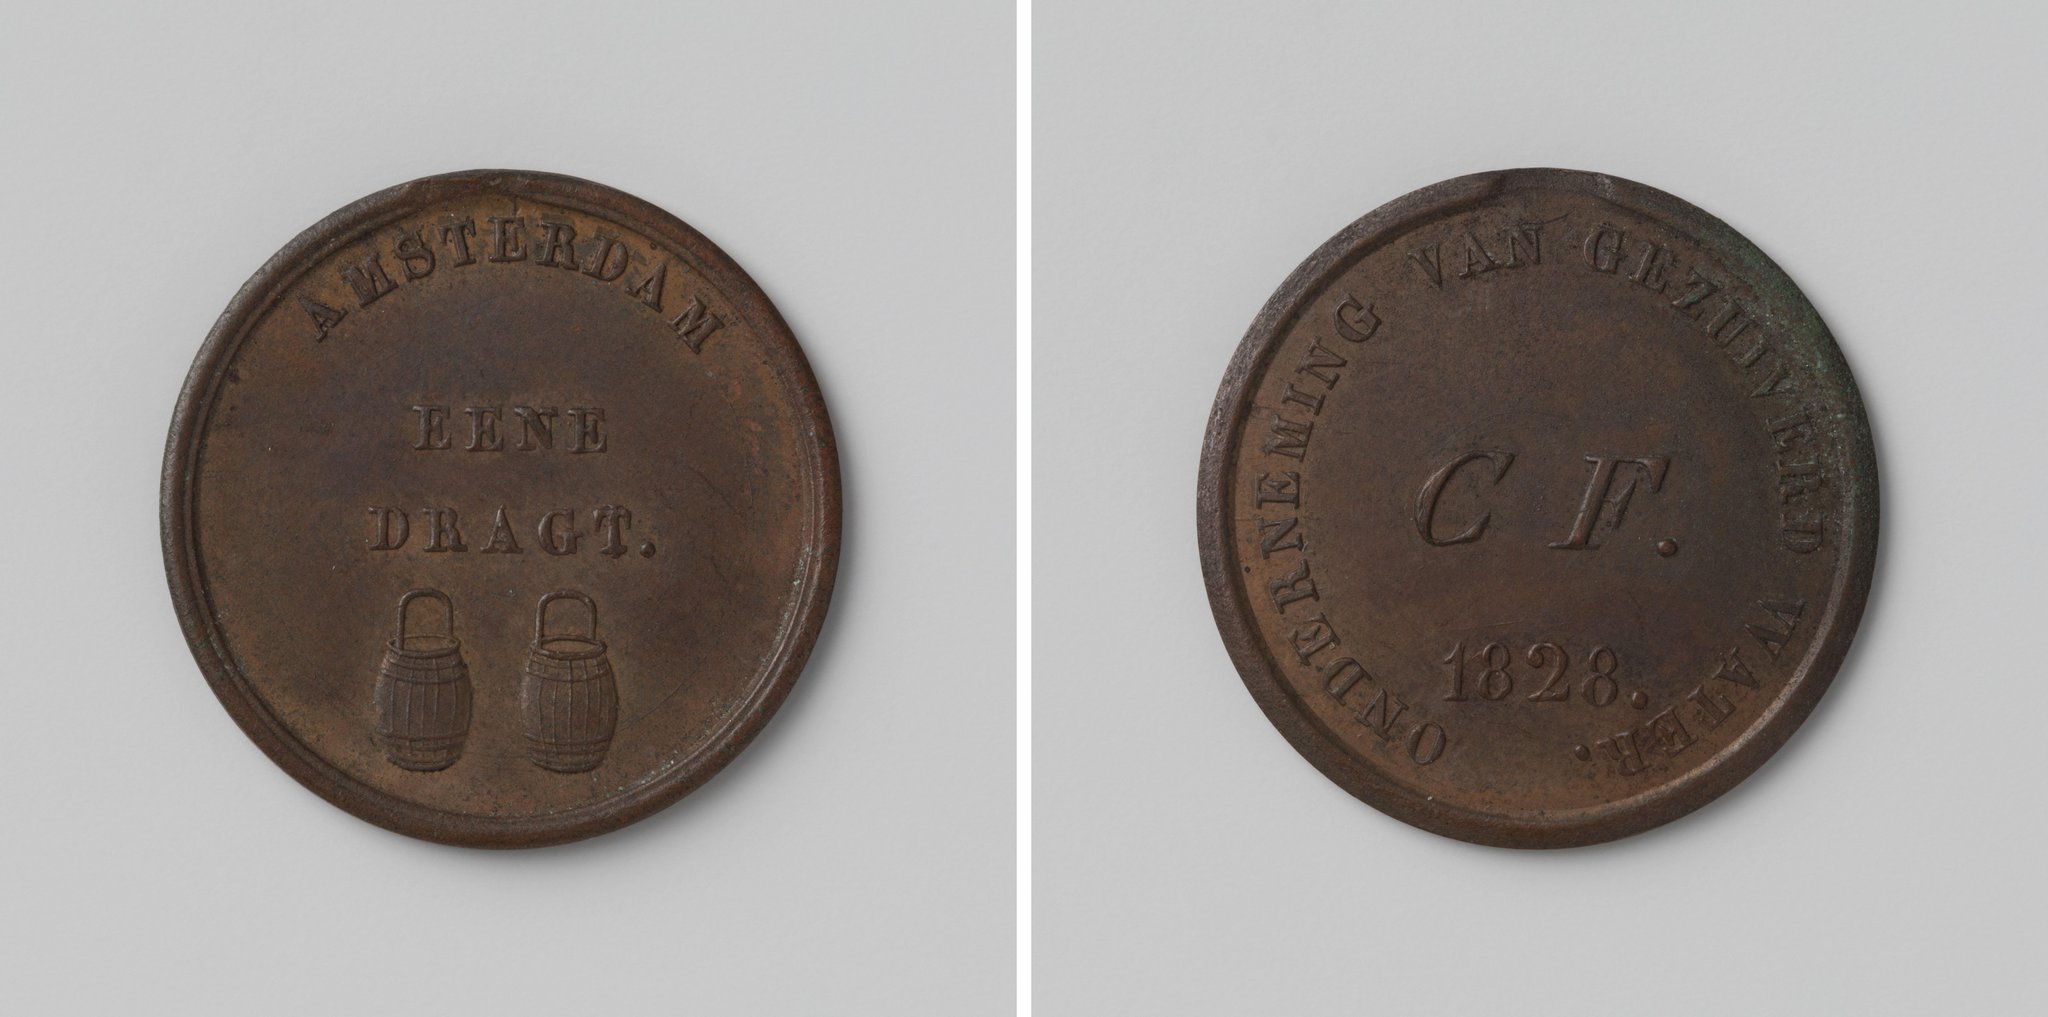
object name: armenloodje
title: Onderneming van gezuiverd water te Amsterdam, loodje goed voor een dragt water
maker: Anonymous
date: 1828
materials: copper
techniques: striking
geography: amsterdam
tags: amsterdam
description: Koperen penning. Voorzijde: twee wateremmers onder opschrift binnen omschrift. Keerzijde: letters C.F boven jaartal binnen omschrift.